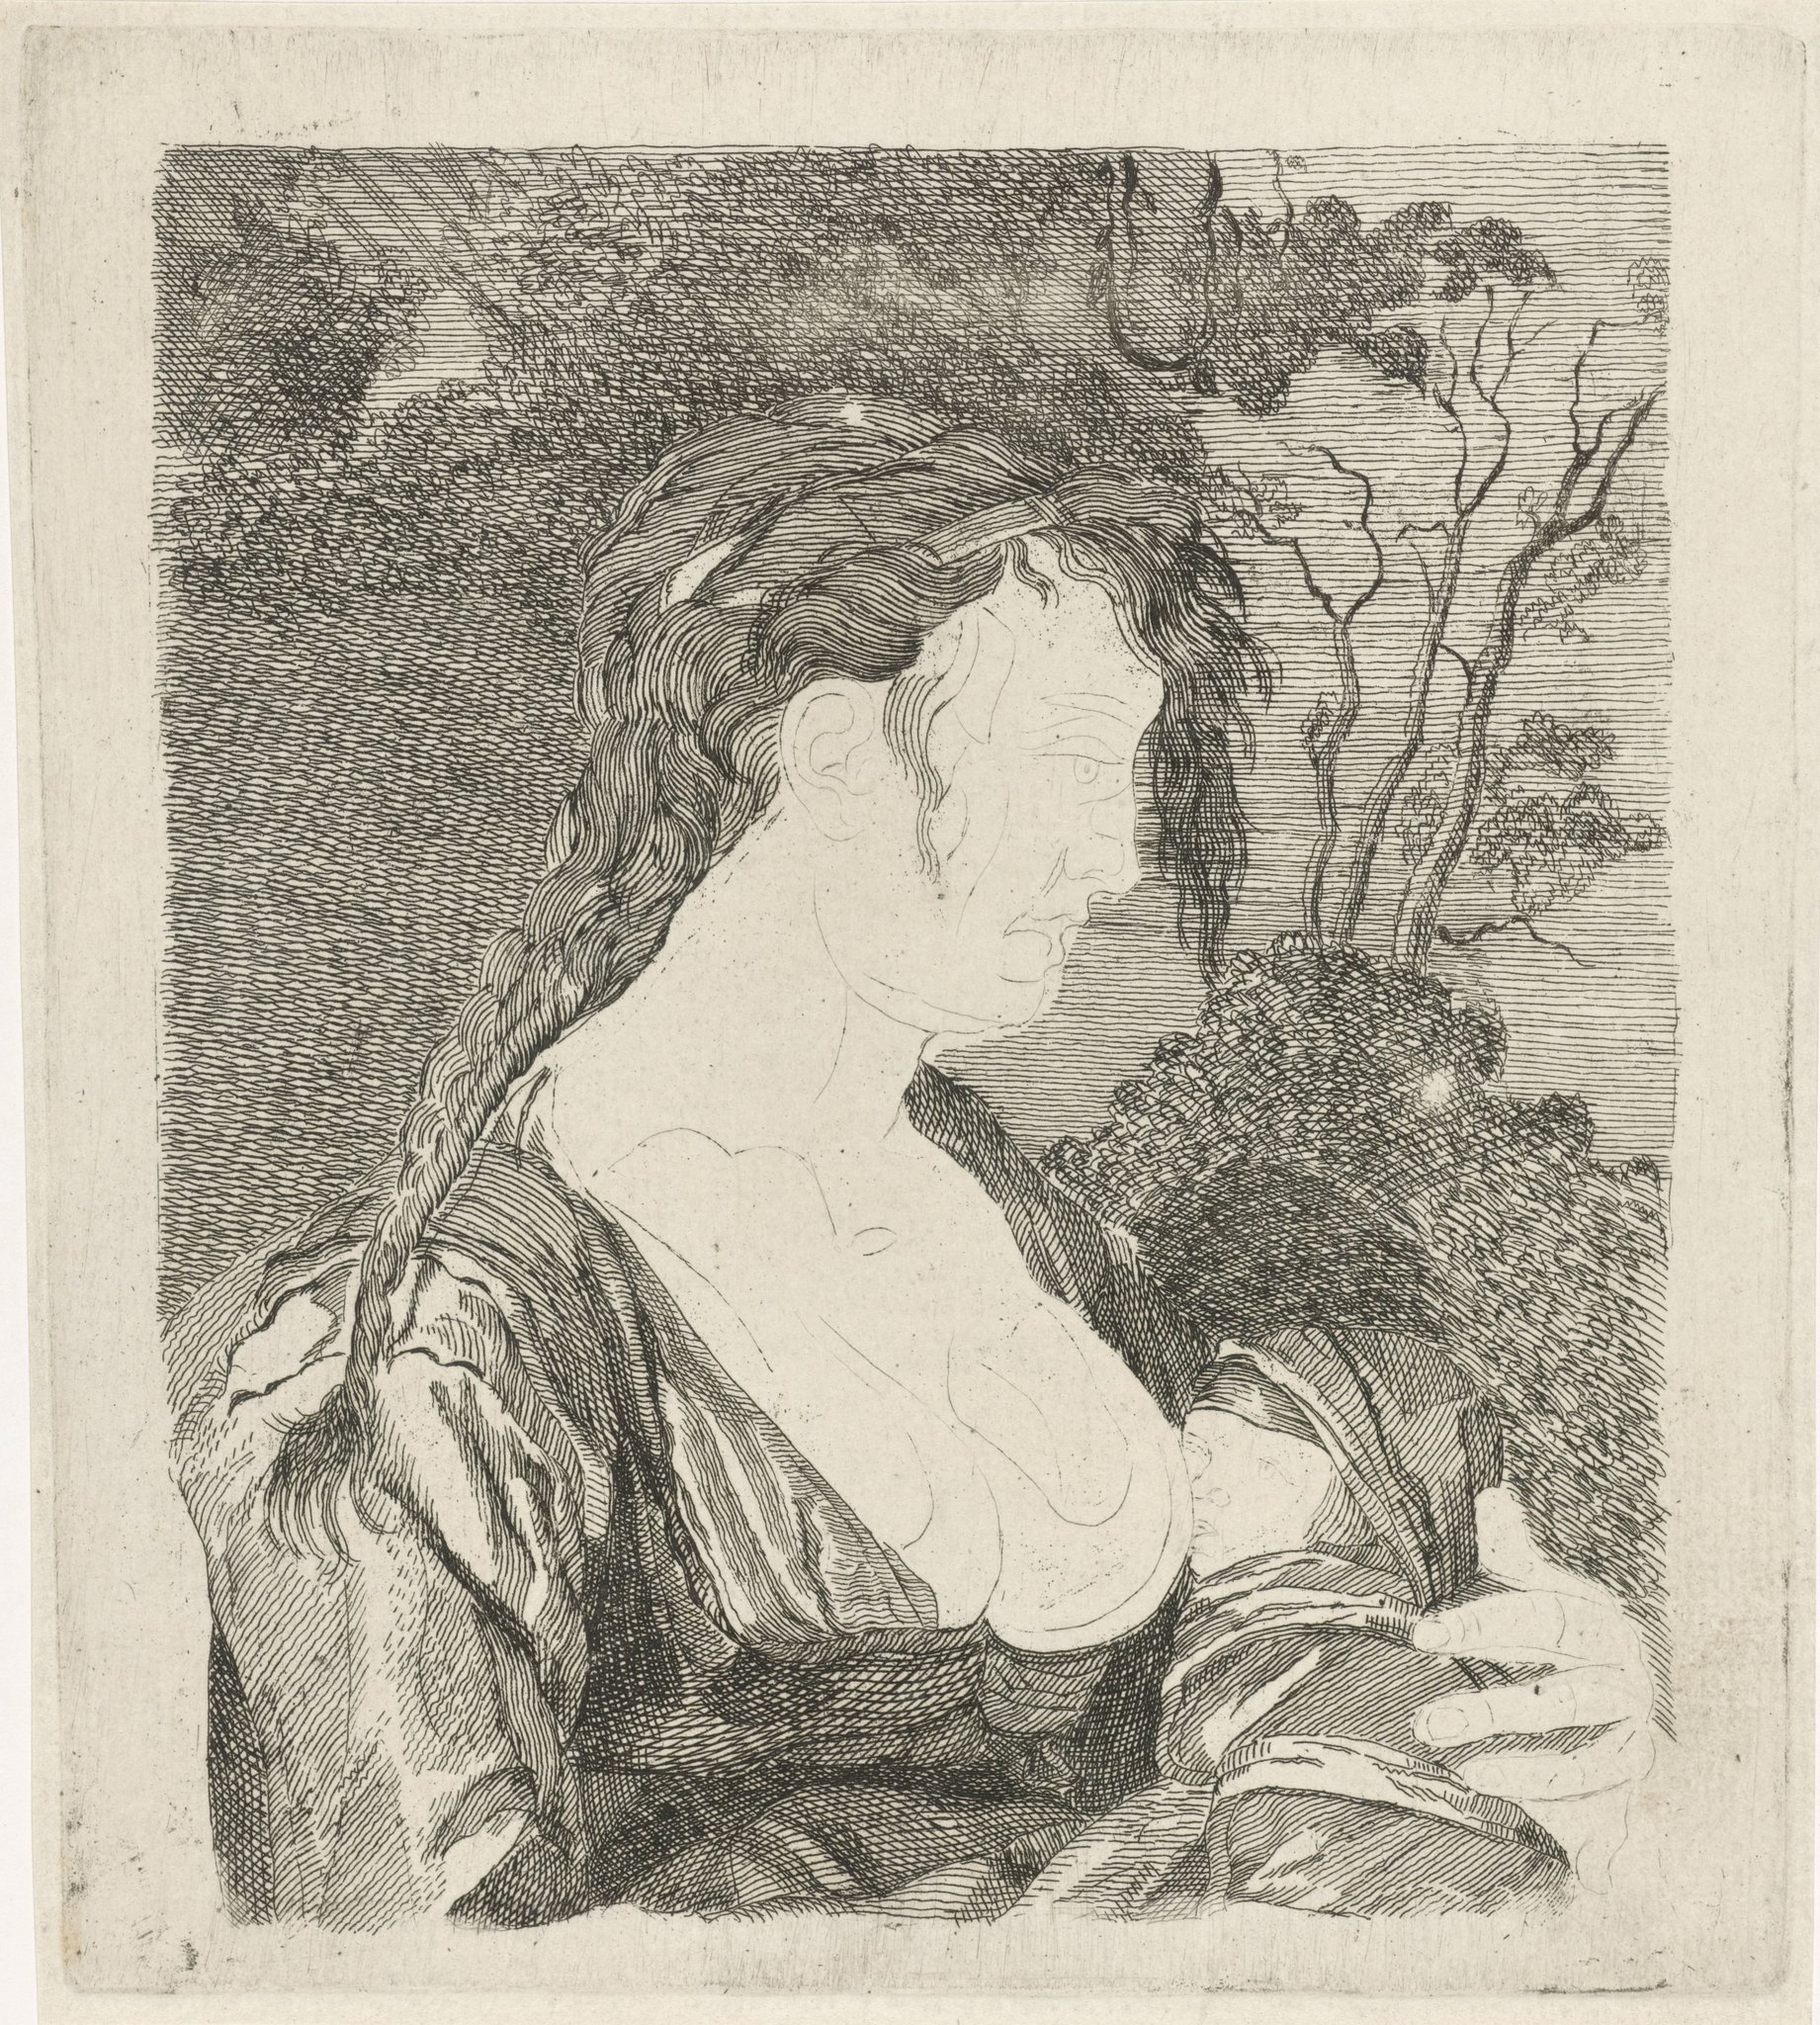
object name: print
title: Zogende moeder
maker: pieter de mare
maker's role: print maker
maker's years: 1758-1796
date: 1768-1796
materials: paper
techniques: etching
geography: leiden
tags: nursing, suckling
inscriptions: collector's mark: Lugt 240